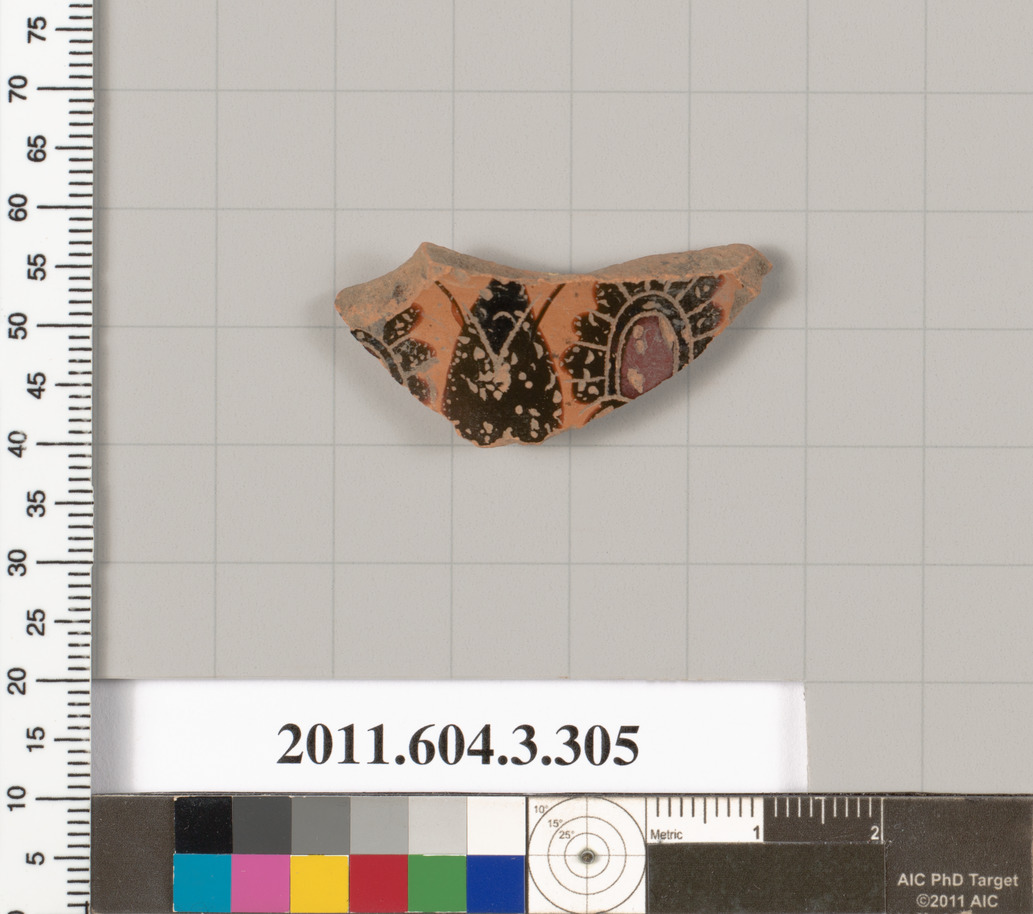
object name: neck amphora fragment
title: Terracotta fragment of a neck-amphora (jar)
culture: greek, attic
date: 525-501 BCE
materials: terracotta